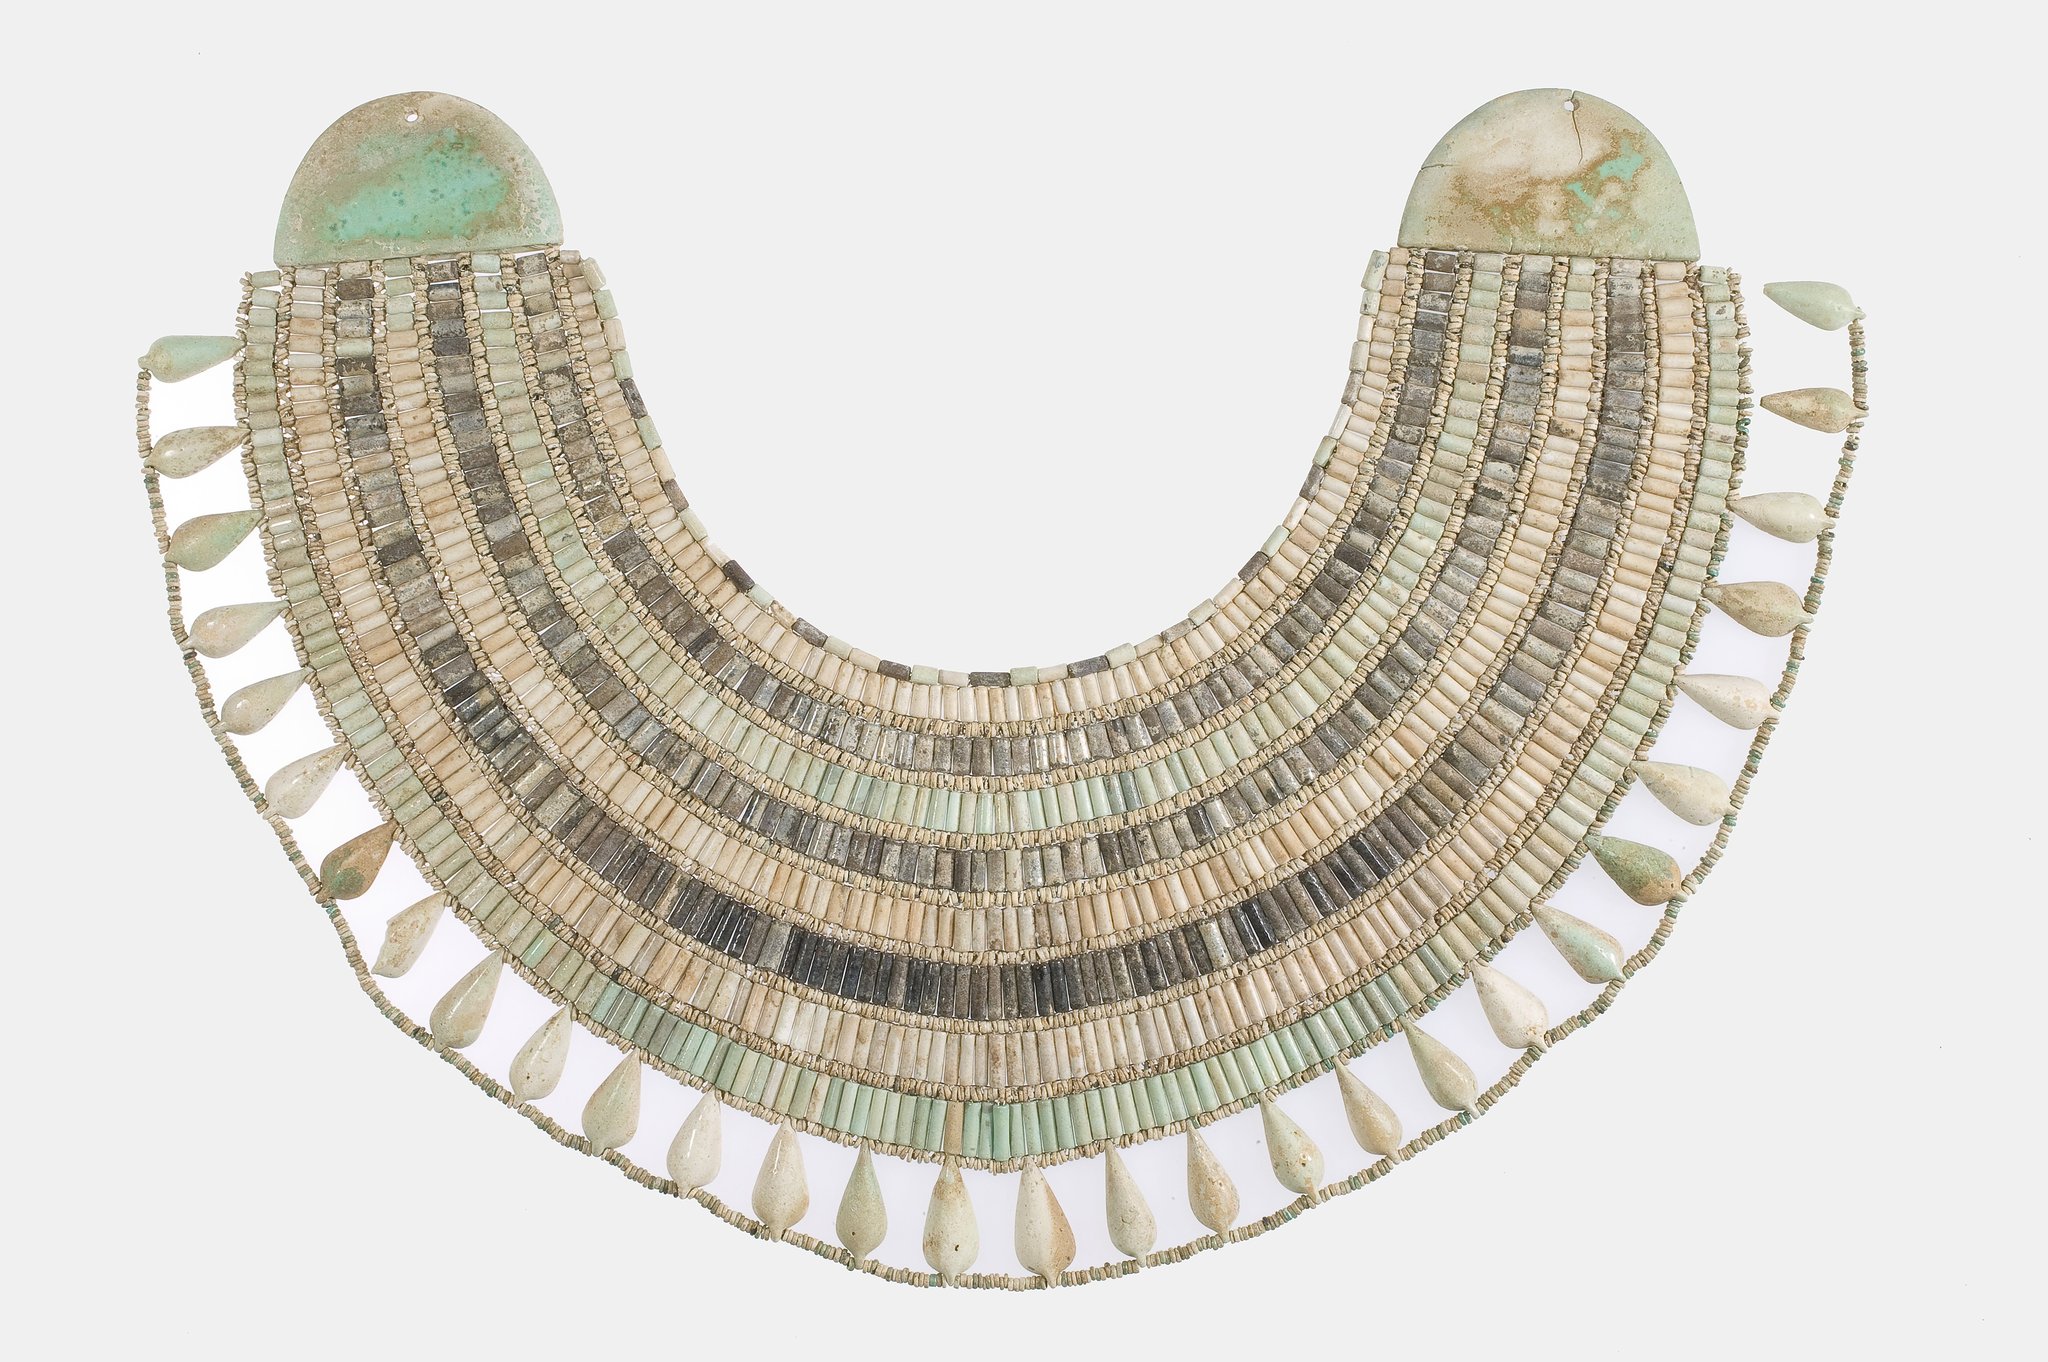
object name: broad collar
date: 1981-1640 BCE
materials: faience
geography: egypt